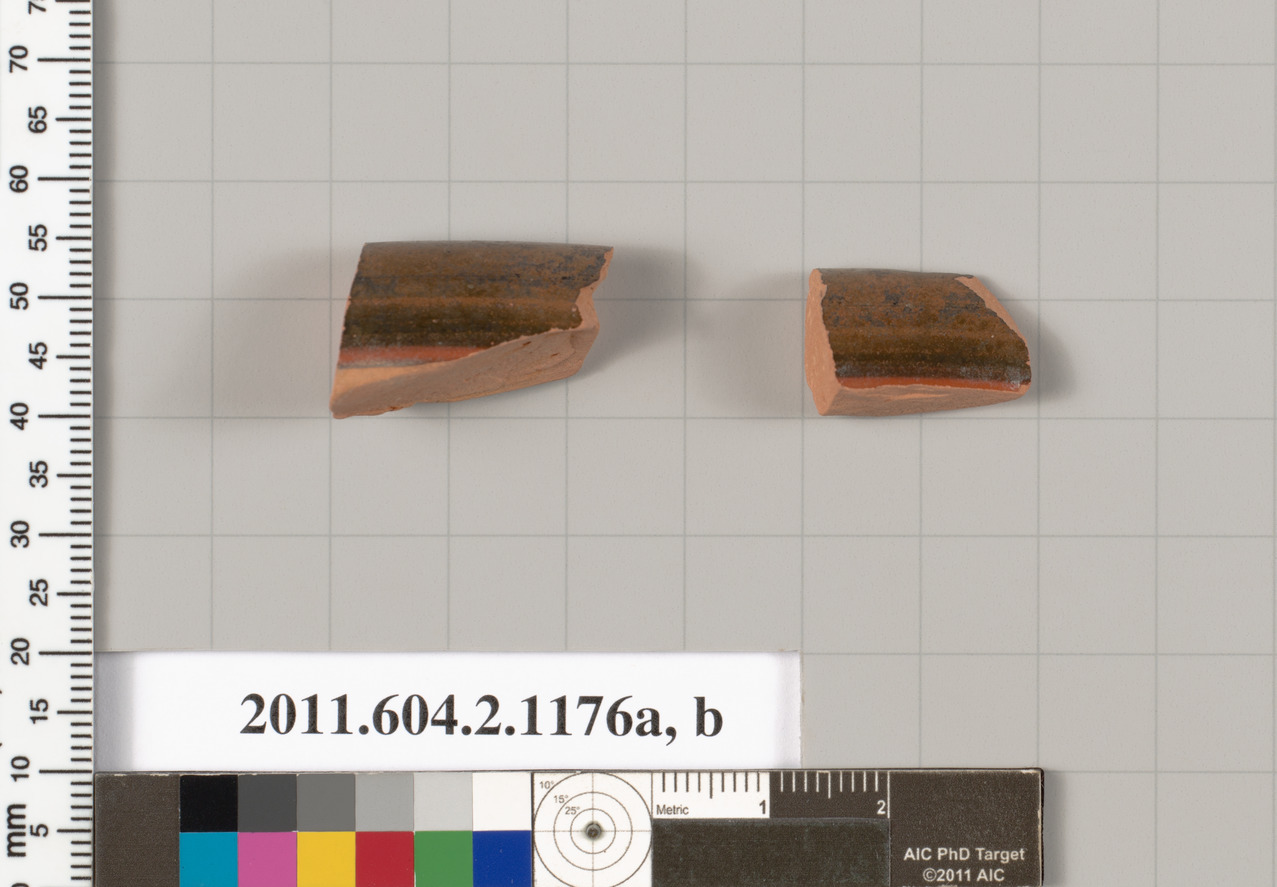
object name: skyphos fragment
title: Terracotta fragments of a skyphos (deep drinking cup)?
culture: greek, attic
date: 475-425 BCE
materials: terracotta